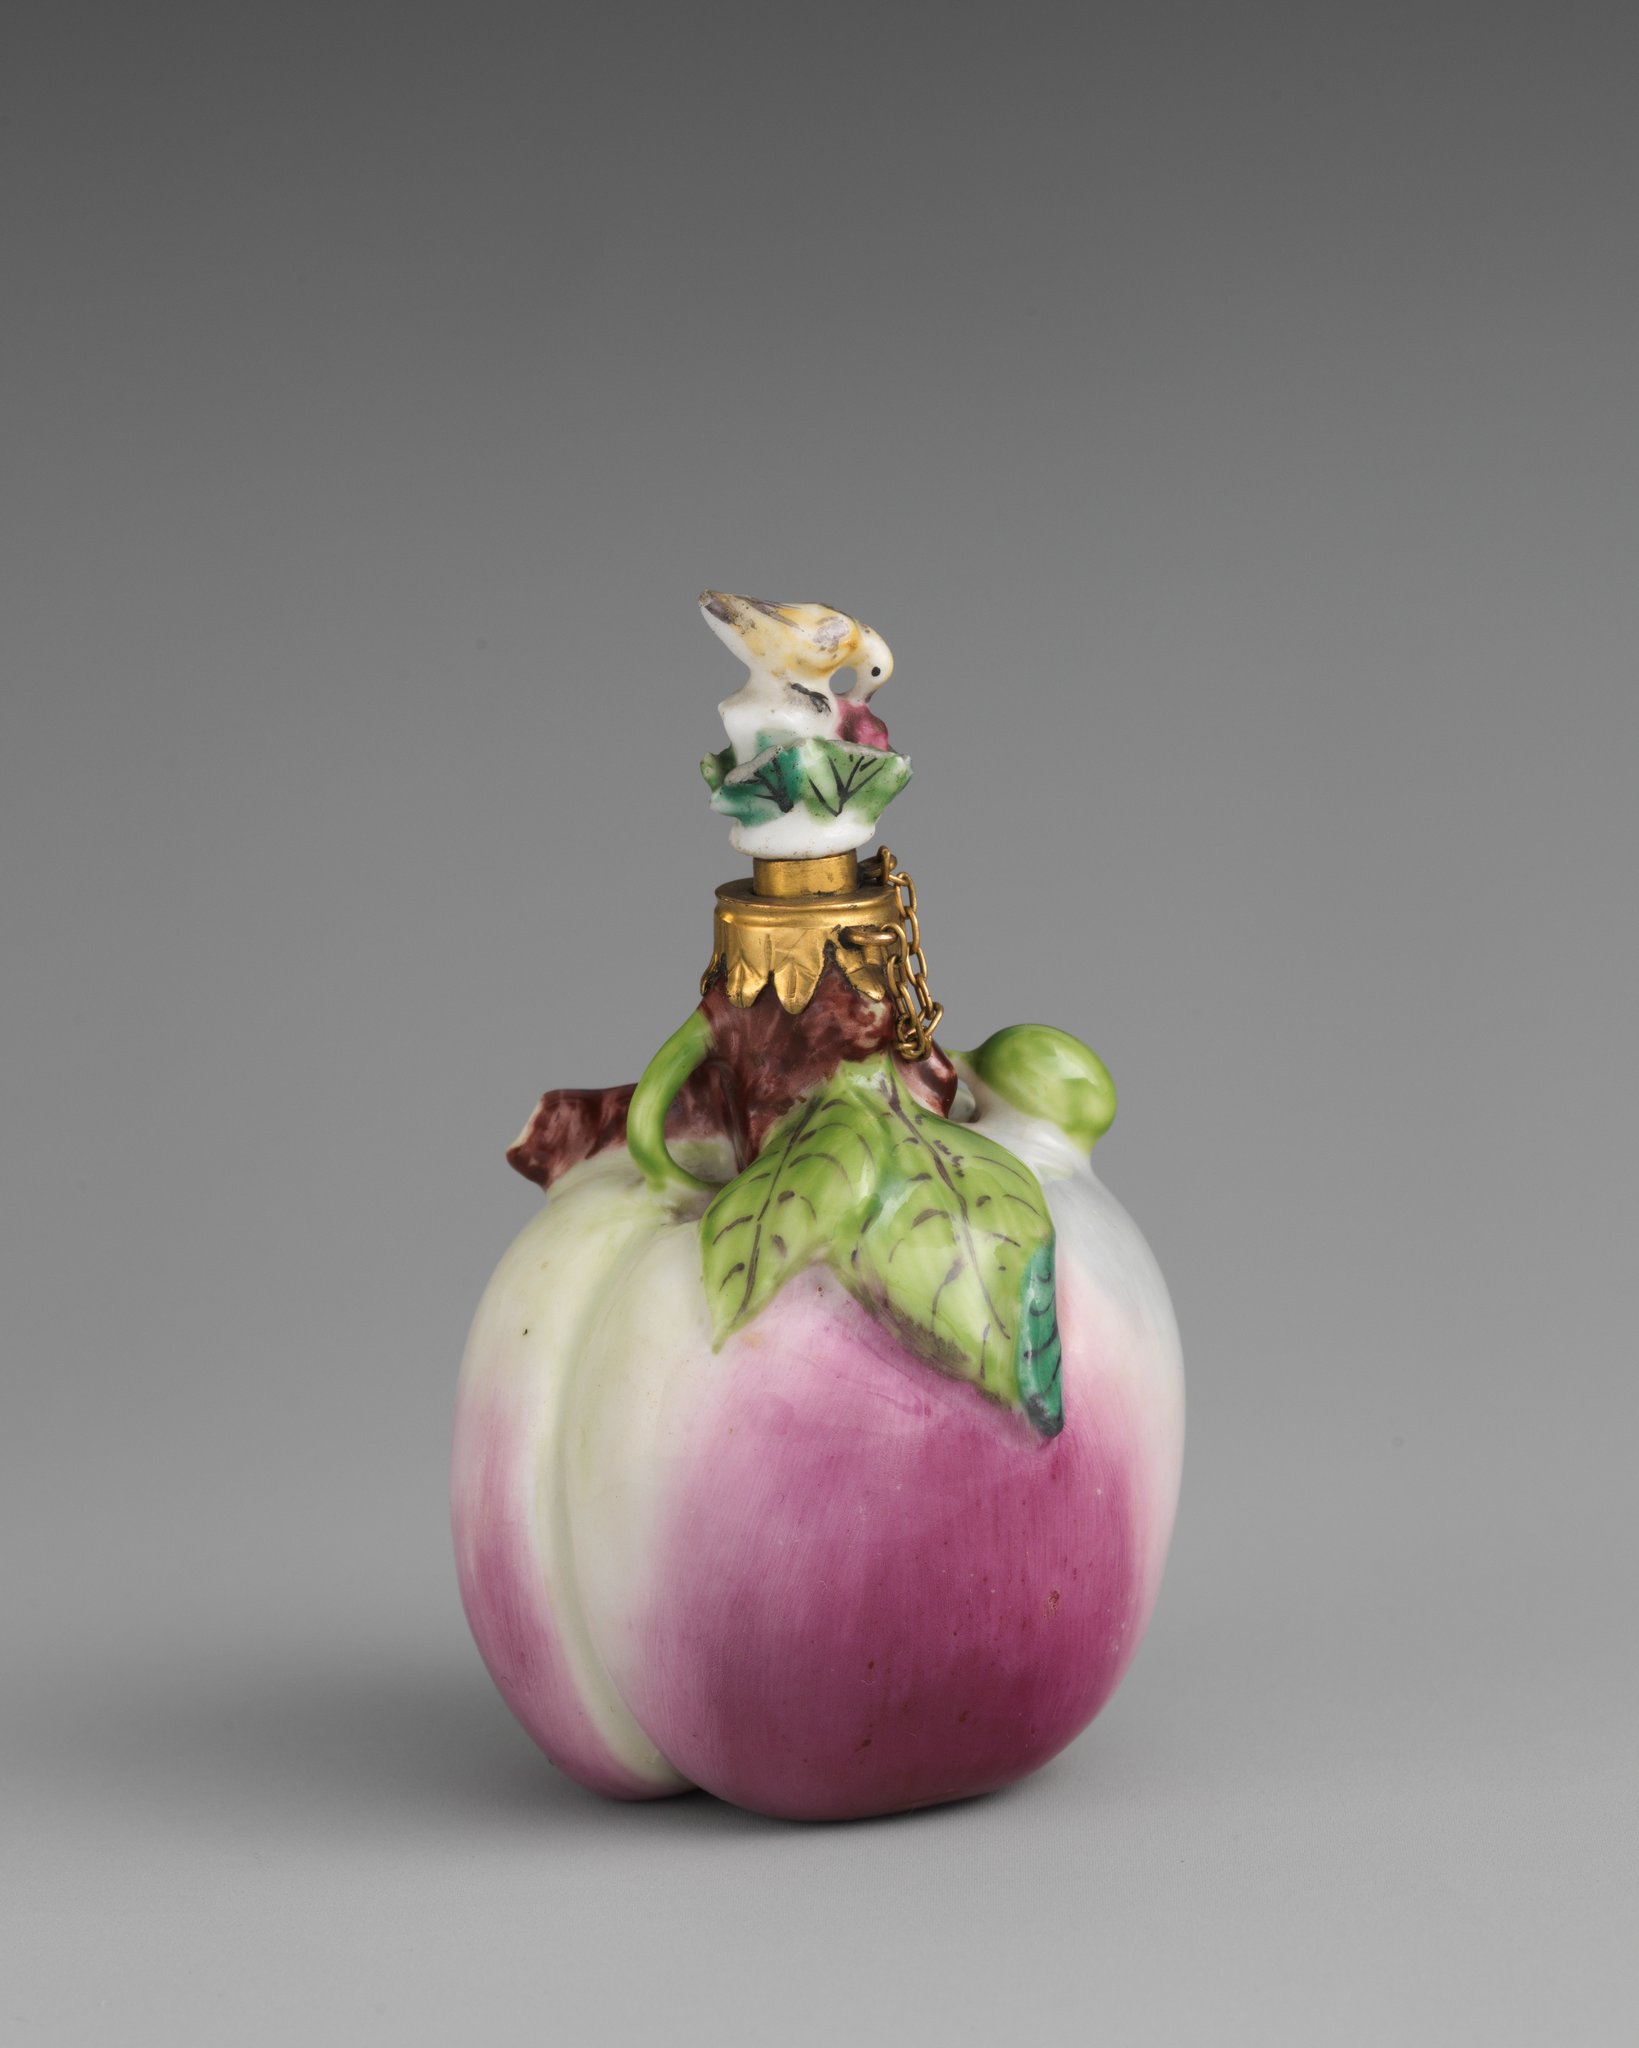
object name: toy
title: Apple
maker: saint james's factory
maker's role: maker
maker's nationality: british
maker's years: 1749-1759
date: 1755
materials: soft paste porcelain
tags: birds,apples